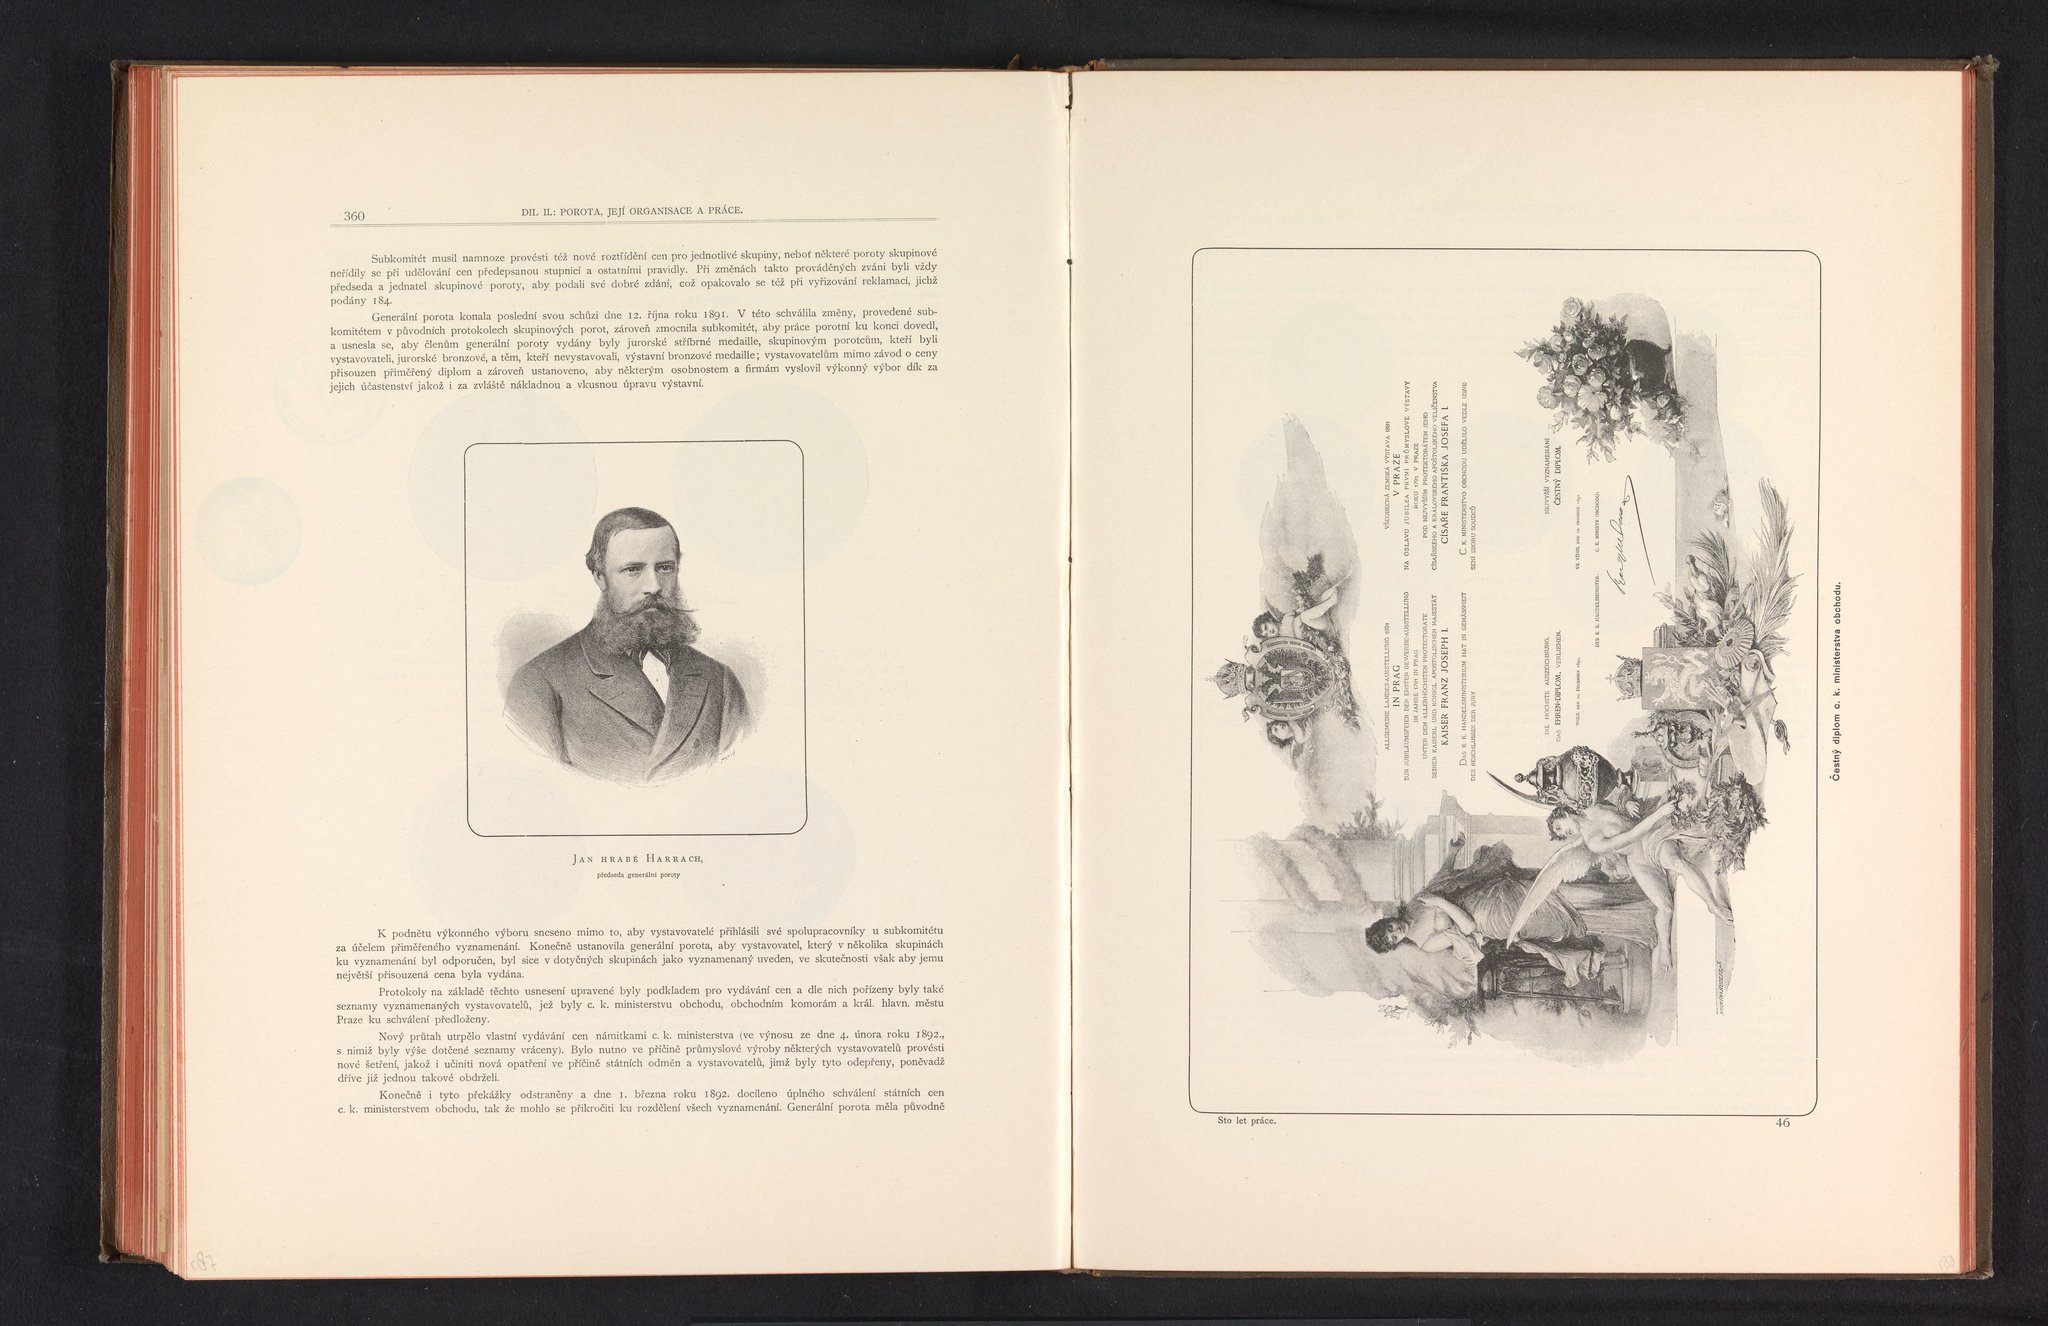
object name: reproduction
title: Cestny diplom c. k. ministerstva obchodu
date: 1891-1893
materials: paper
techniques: autotype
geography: prague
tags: single printed leaf: broadsheet, leaflet, angels